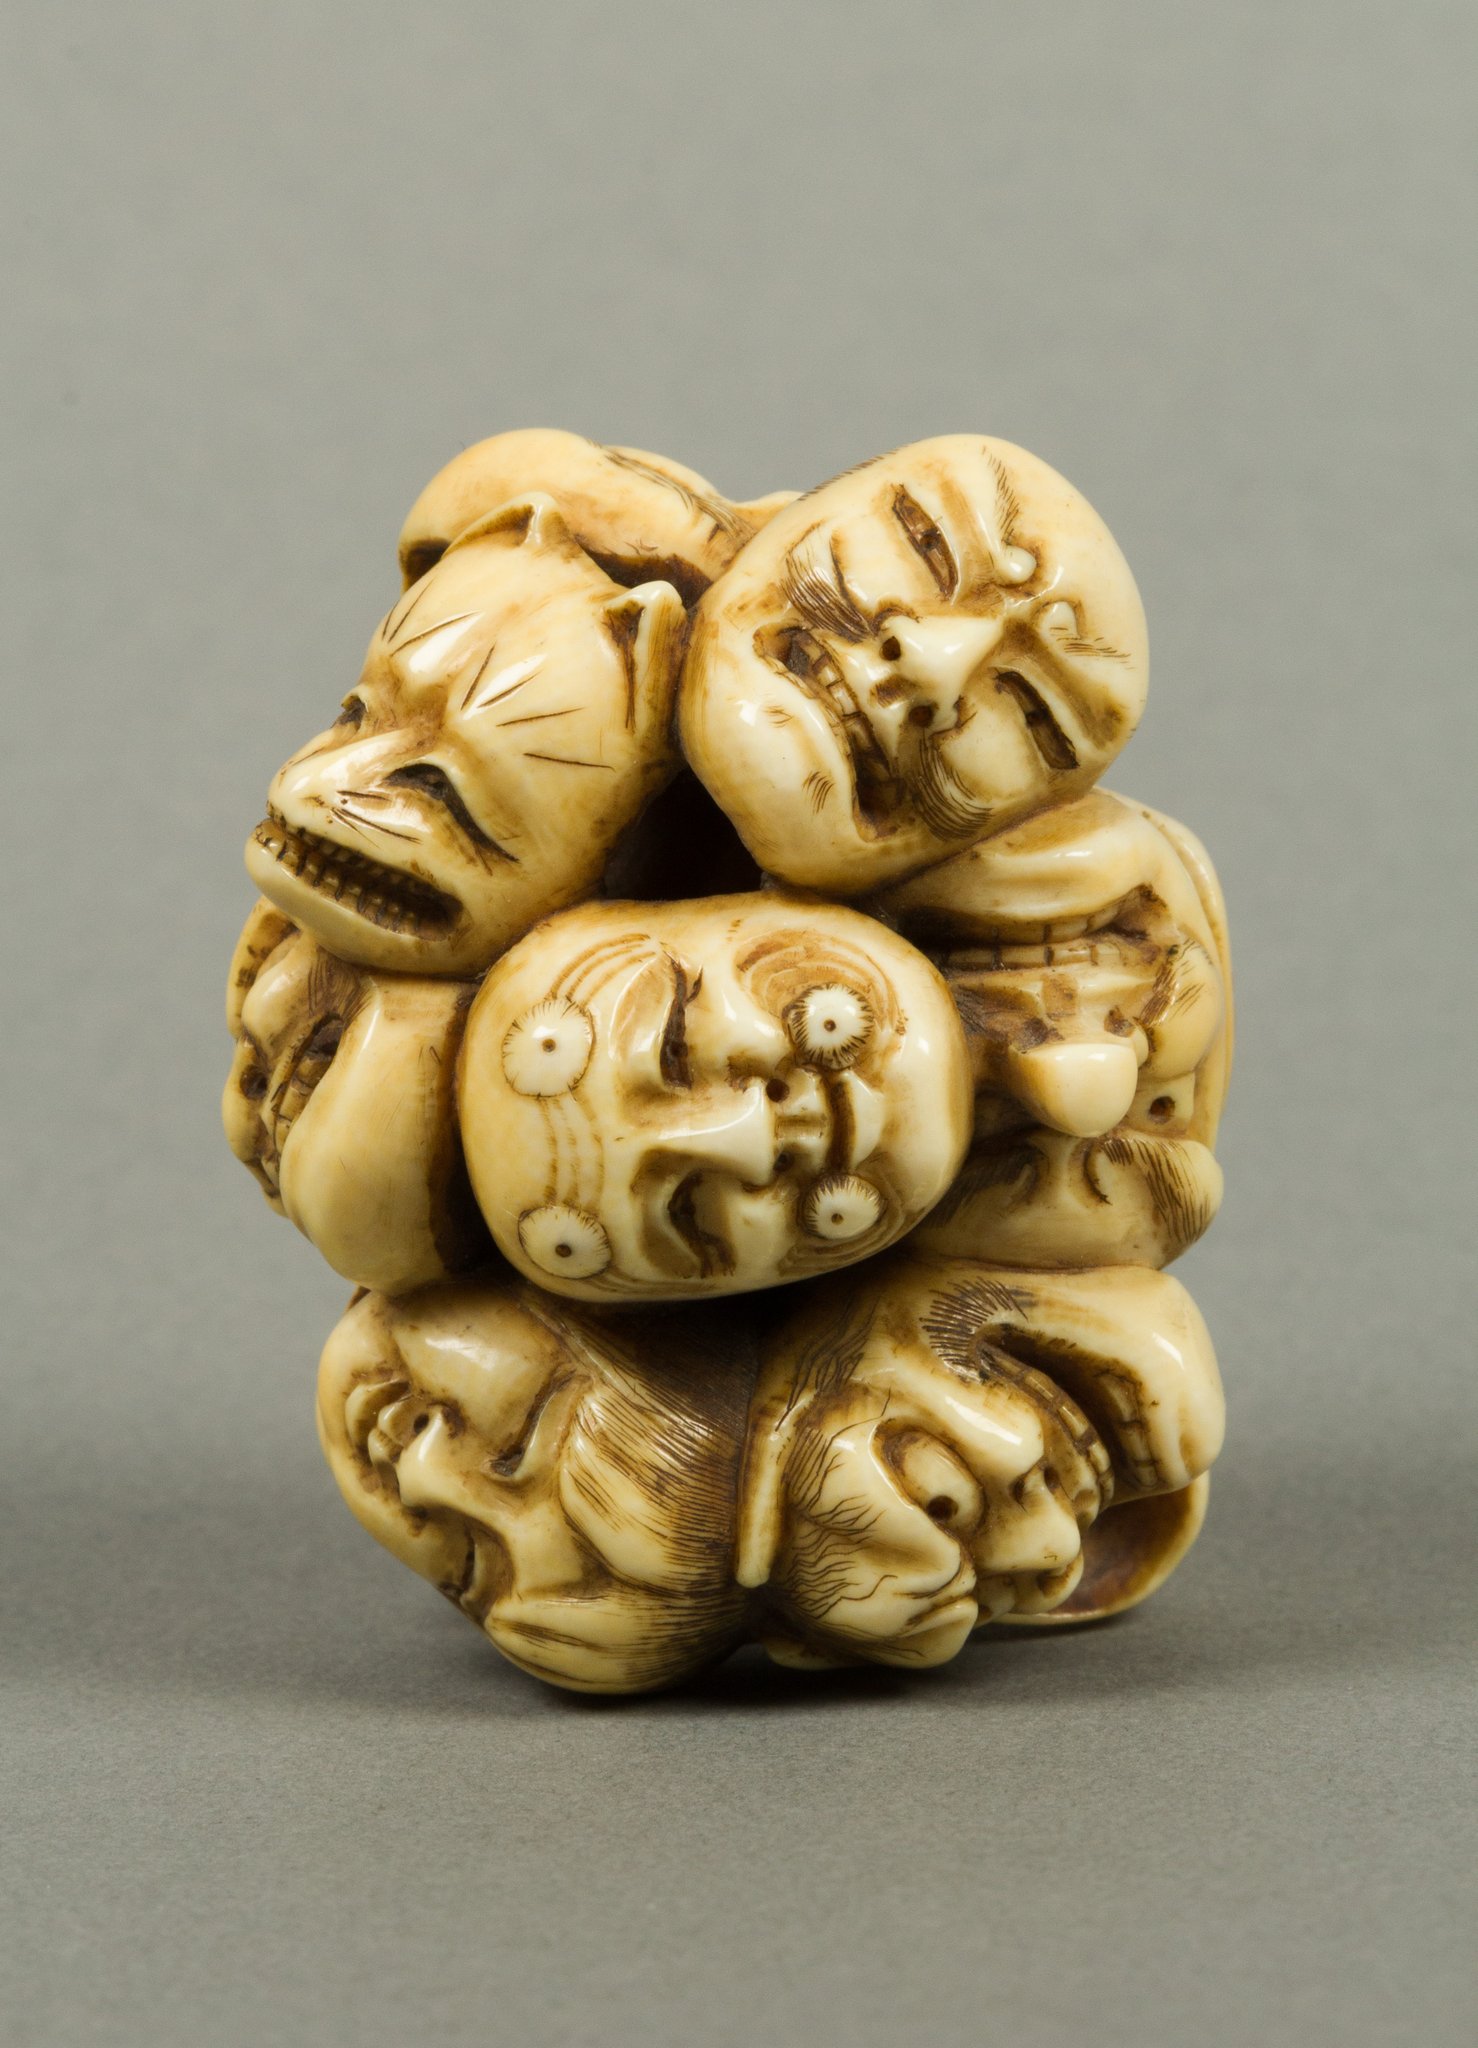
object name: netsuke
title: Netsuke of Thirteen Masks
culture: japanese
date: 1801-1900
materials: ivory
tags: masks